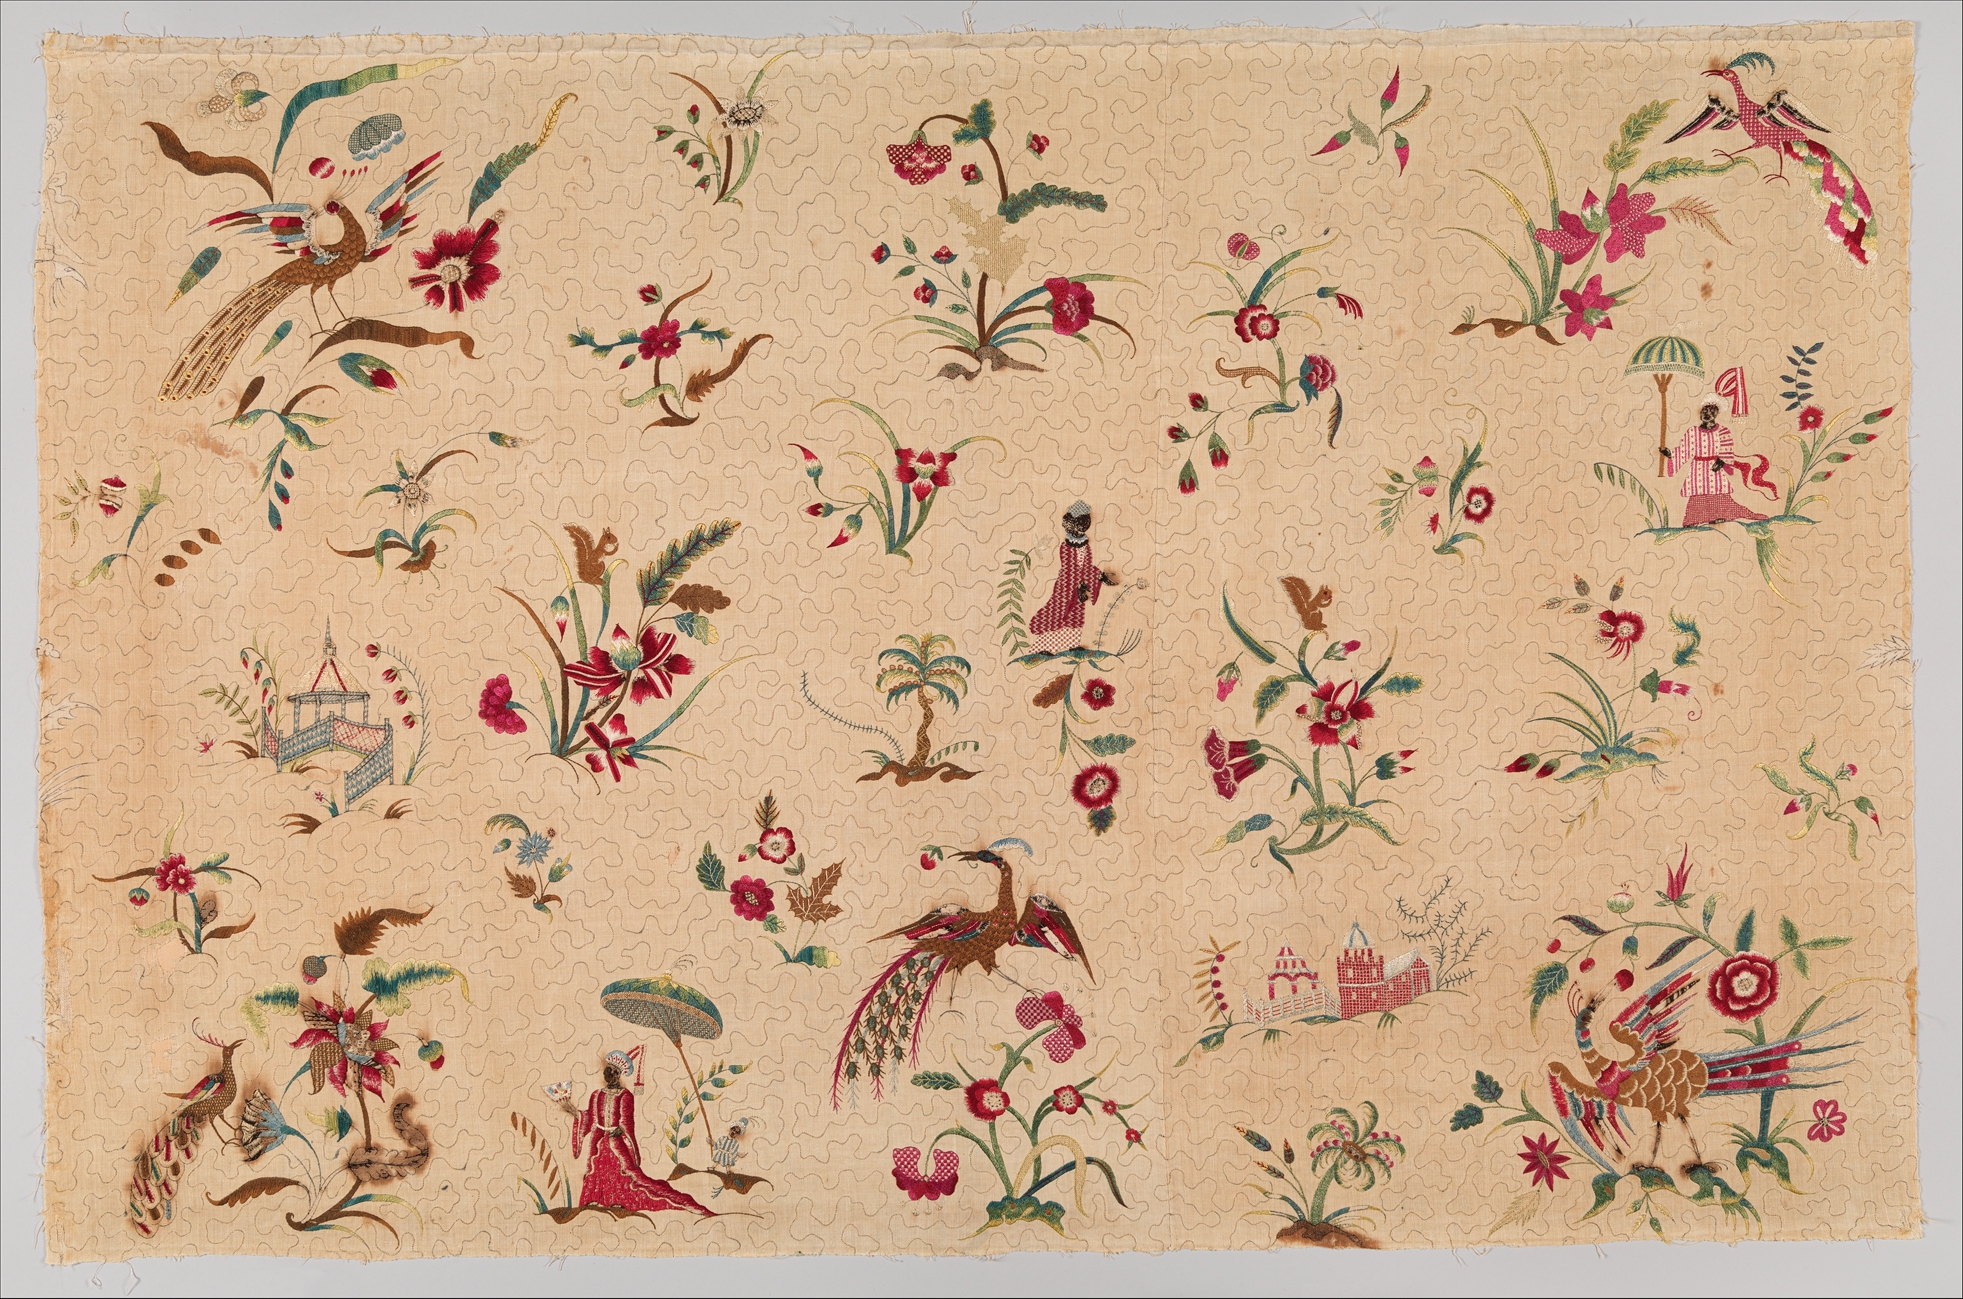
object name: panel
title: Panel for a skirt or petticoat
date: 1690-1710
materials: linen, silk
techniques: embroidery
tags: human figures,birds,chinoiserie,flowers